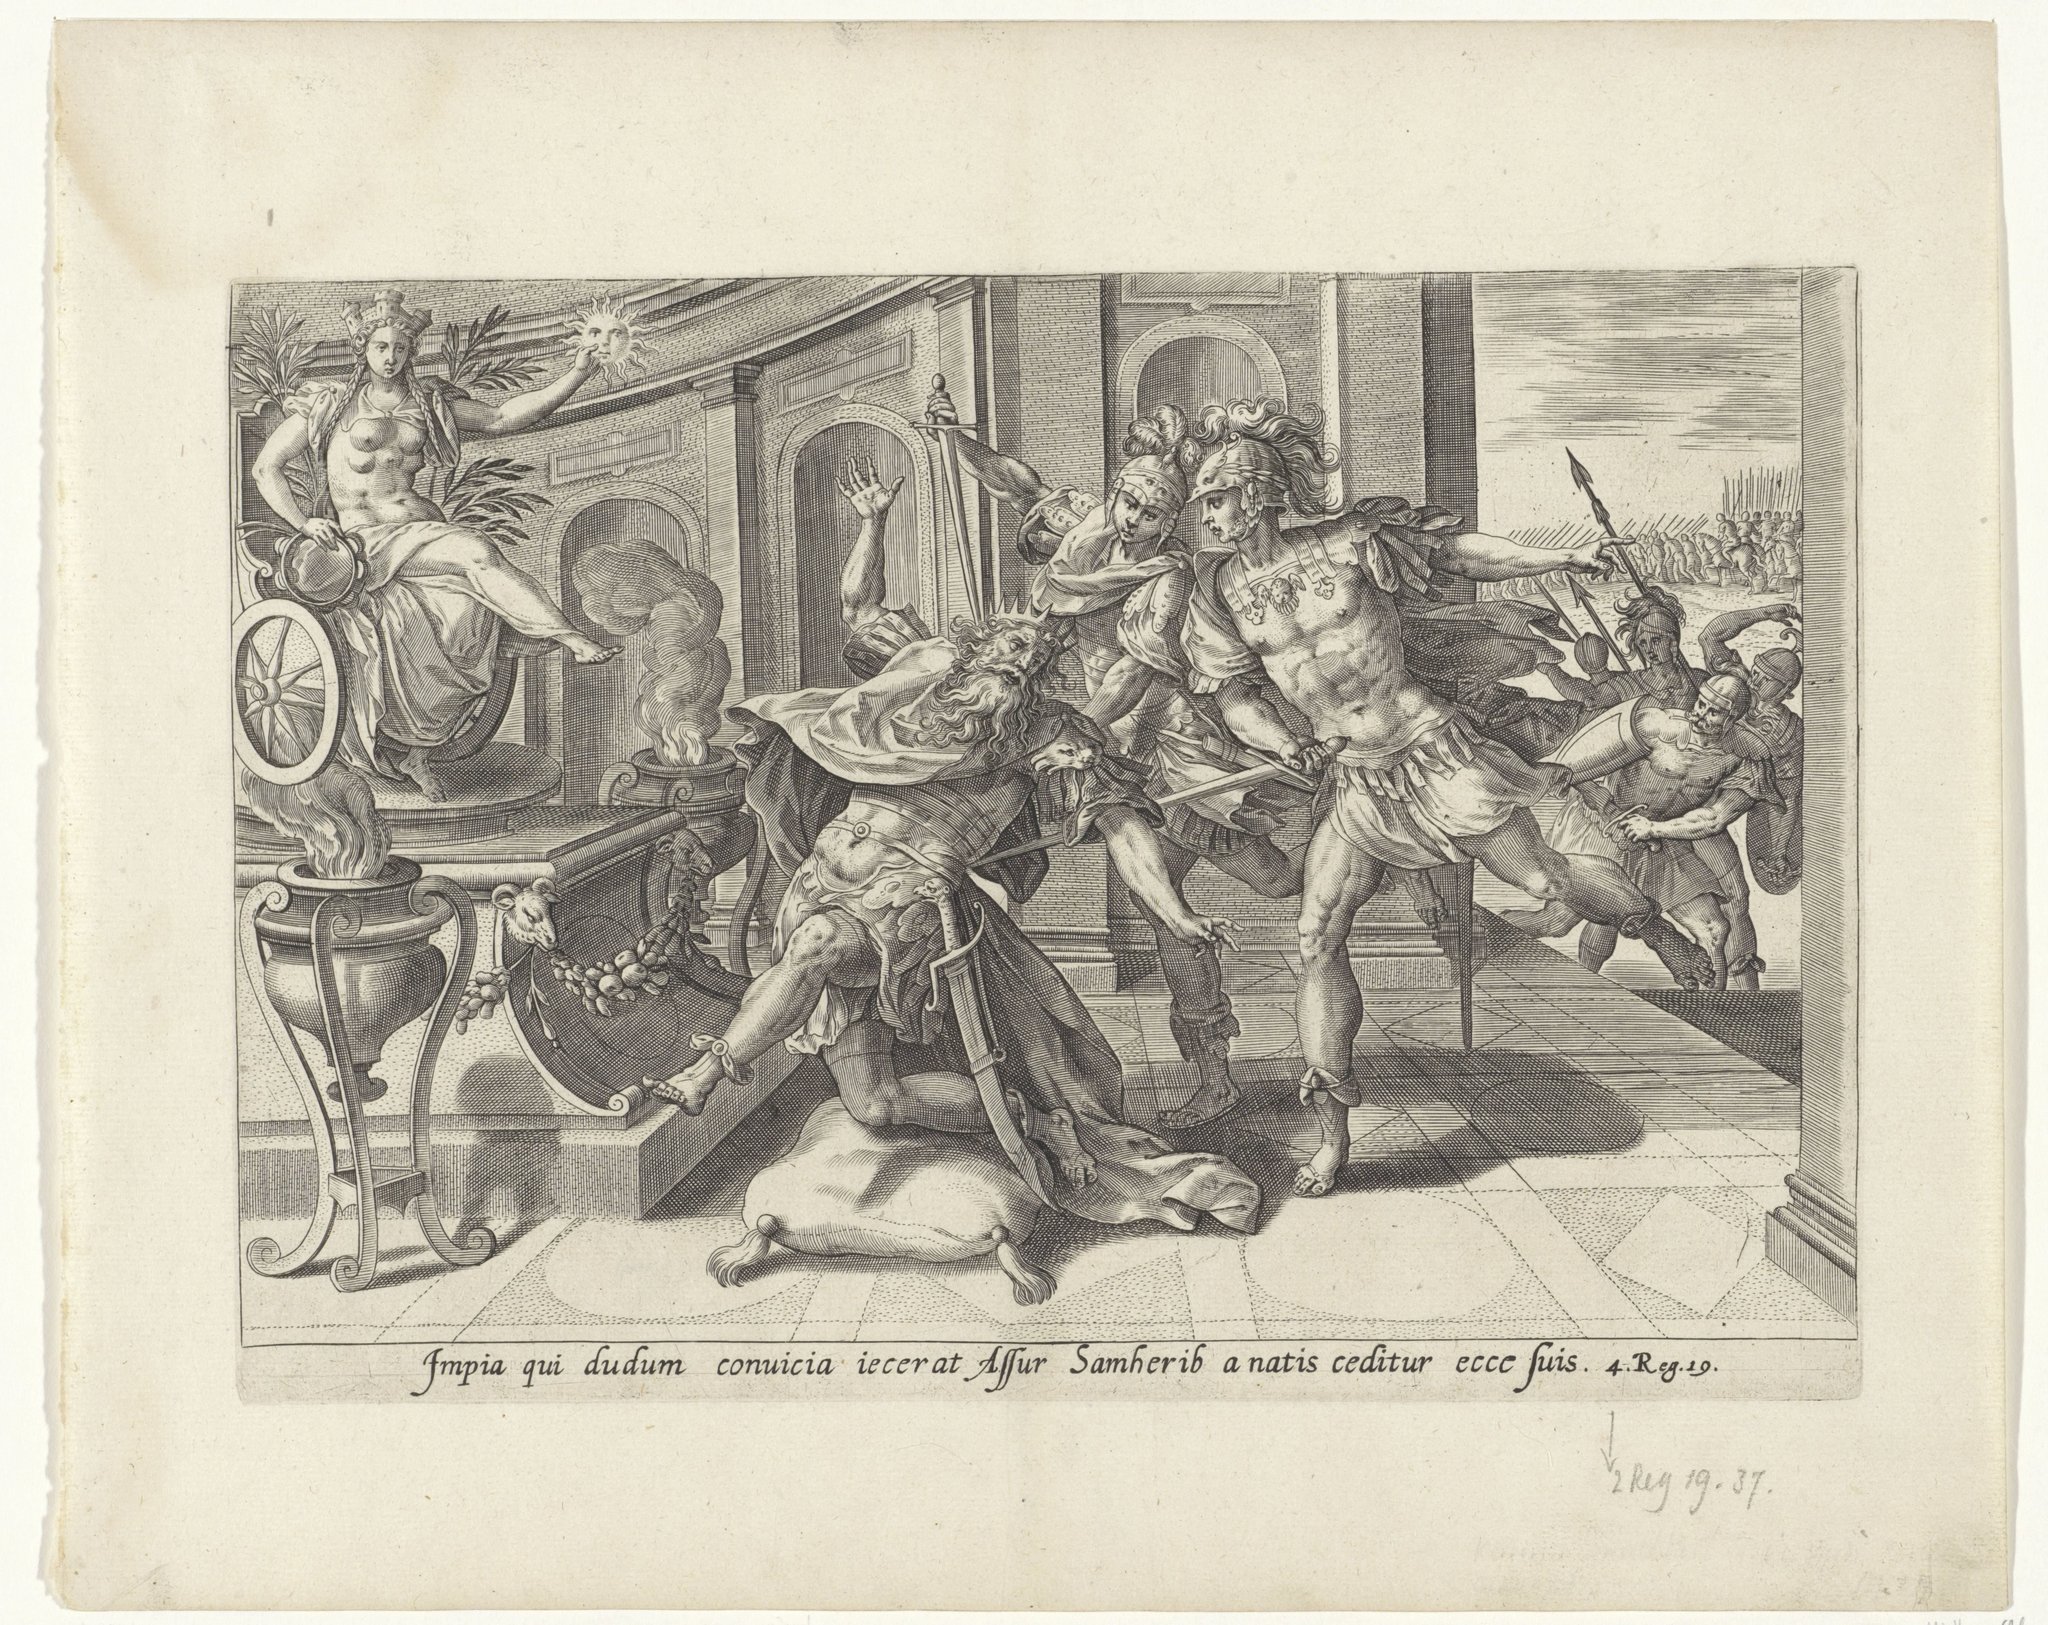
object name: print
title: Geschiedenis van Hizkia en Sanherib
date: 1585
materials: paper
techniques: engraving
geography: antwerp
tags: when sennacherib is worshipping in the temple, two of his sons kill him with their swords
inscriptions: collector's mark: Lugt 2228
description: Prent gebruikt in: Thesaurus sacrarum historiaru[m] veteris (et novi) testame[n]ti, elega[n]tissimis imaginibus expressu[m] excelle[n]tissimoru[m] in hac arte viroru[m] opera : nu[n]c primu[m] in luce[m] editus. Antwerpen: Gerard de Jode, 1585.